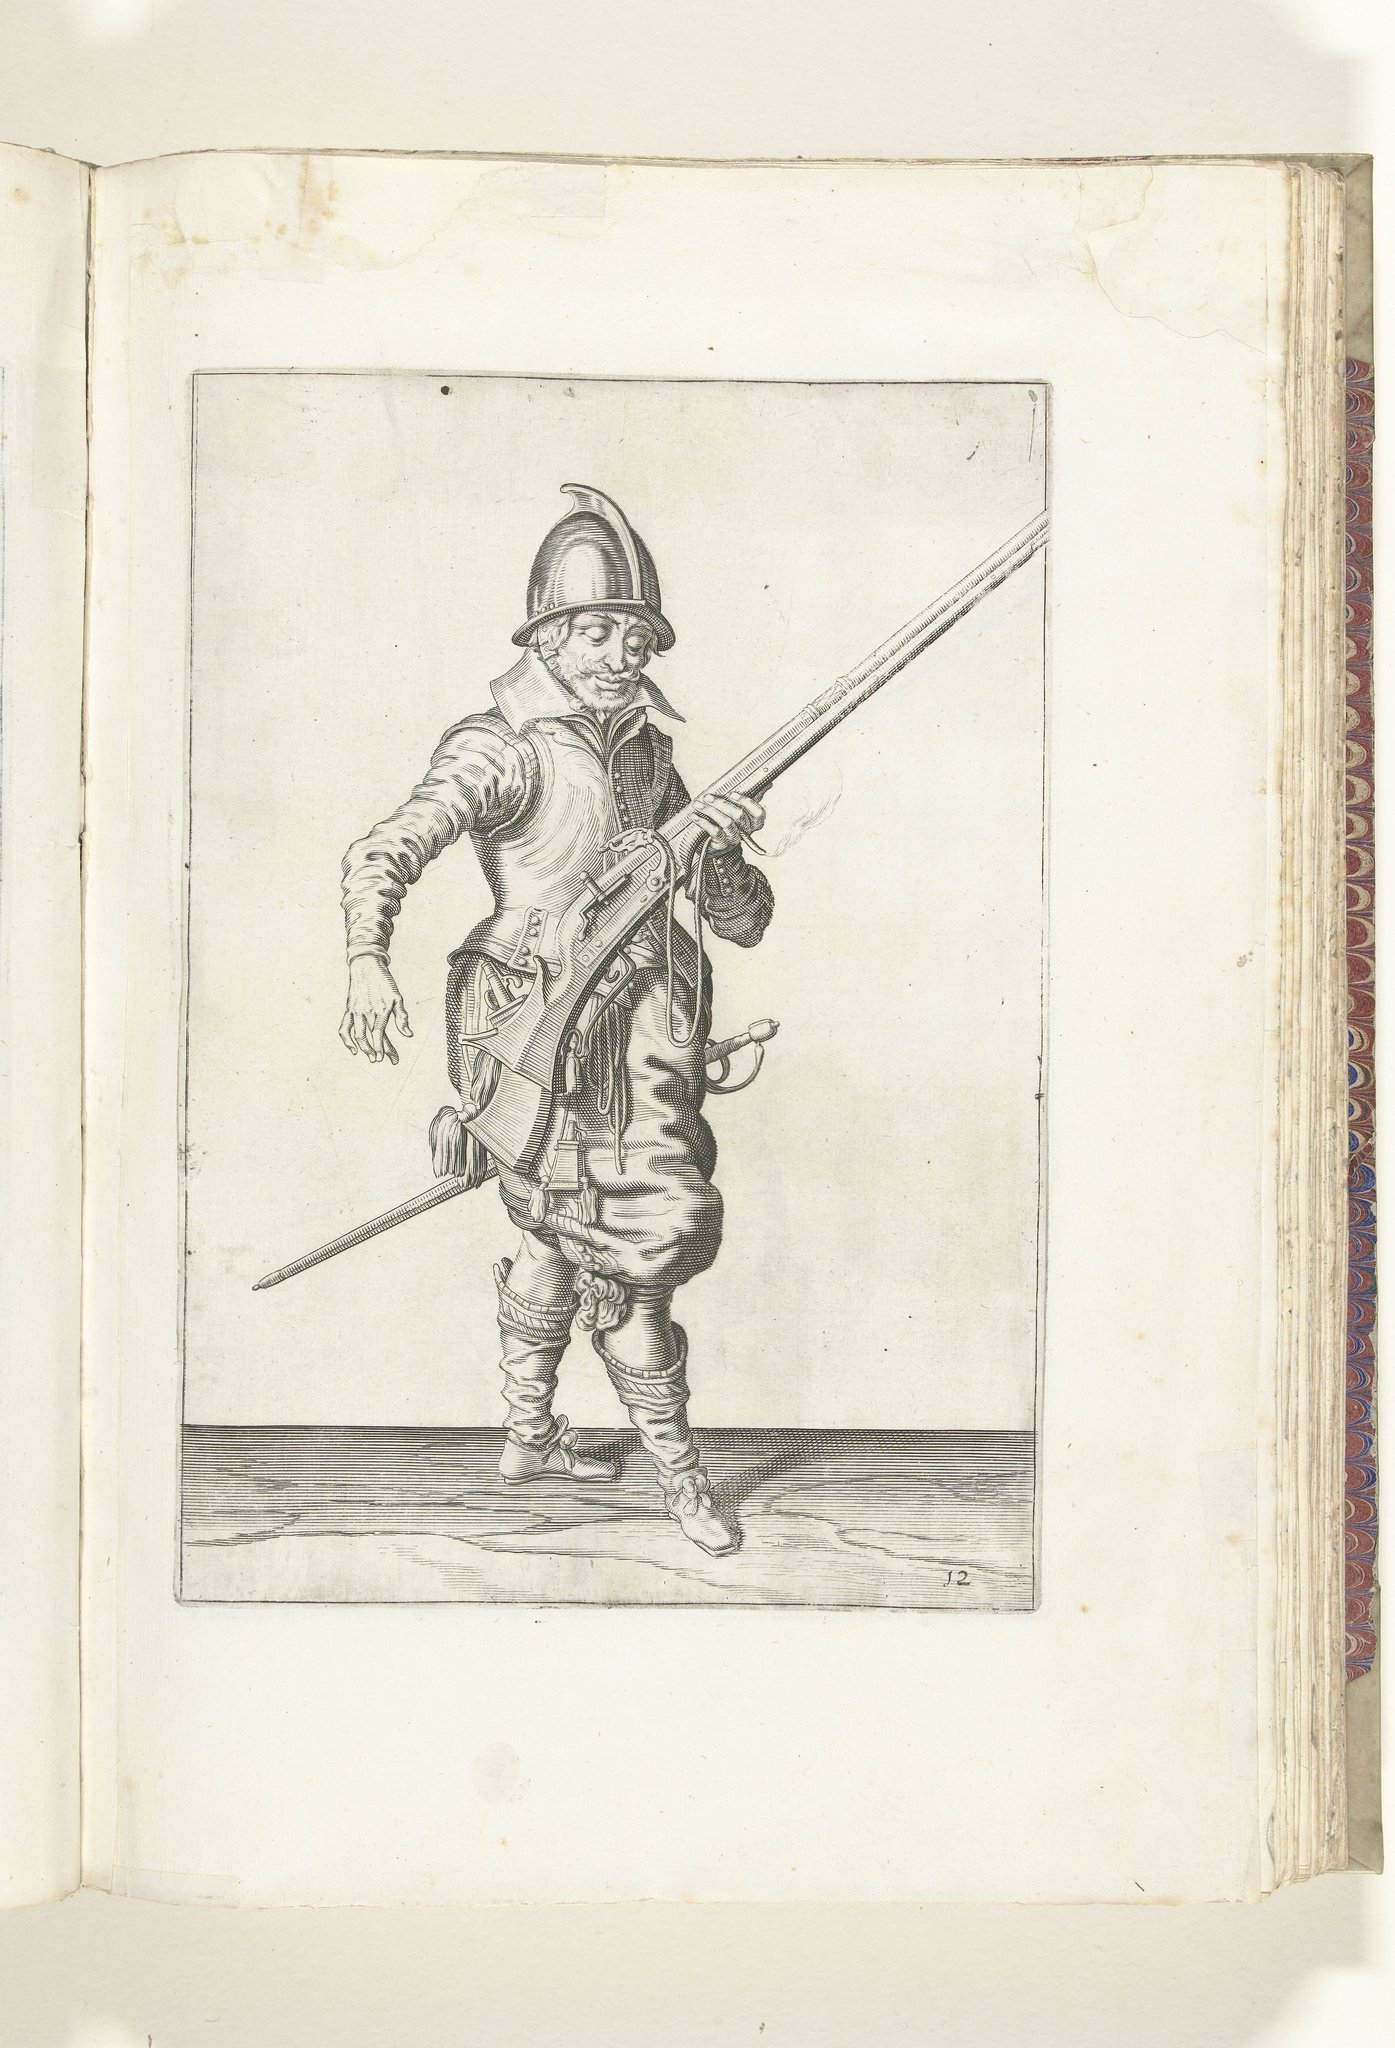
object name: print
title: Soldaat die zijn roer met zijn linkerhand schuin omhoog gericht vasthoudt (nr. 12), ca. 1600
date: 1597-1607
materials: paper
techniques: engraving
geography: northern netherlands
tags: the hague, maurice (prince of orange), handling of weapons ~ military training, weapons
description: Een soldaat, ten voeten uit, naar rechts, die een roer (een bepaald type vuurwapen) met zijn linkerhand vasthoudt, nadat hij gevuurd heeft, de loop schuin omhoog gericht om te voorkomen dat hij ongewild een gezel verwondt (nr. 12), ca. 1600. In zijn linkerhand behalve het roer ook een brandende lont. Plaat 12 in de instructies voor het hanteren van de roer. Onderdeel van de illustraties in: J. de Gheyn, Wapenhandelinghe van Roers Musquetten ende spiessen, Amsterdam, 1608. Krijgswezen rond 1600.